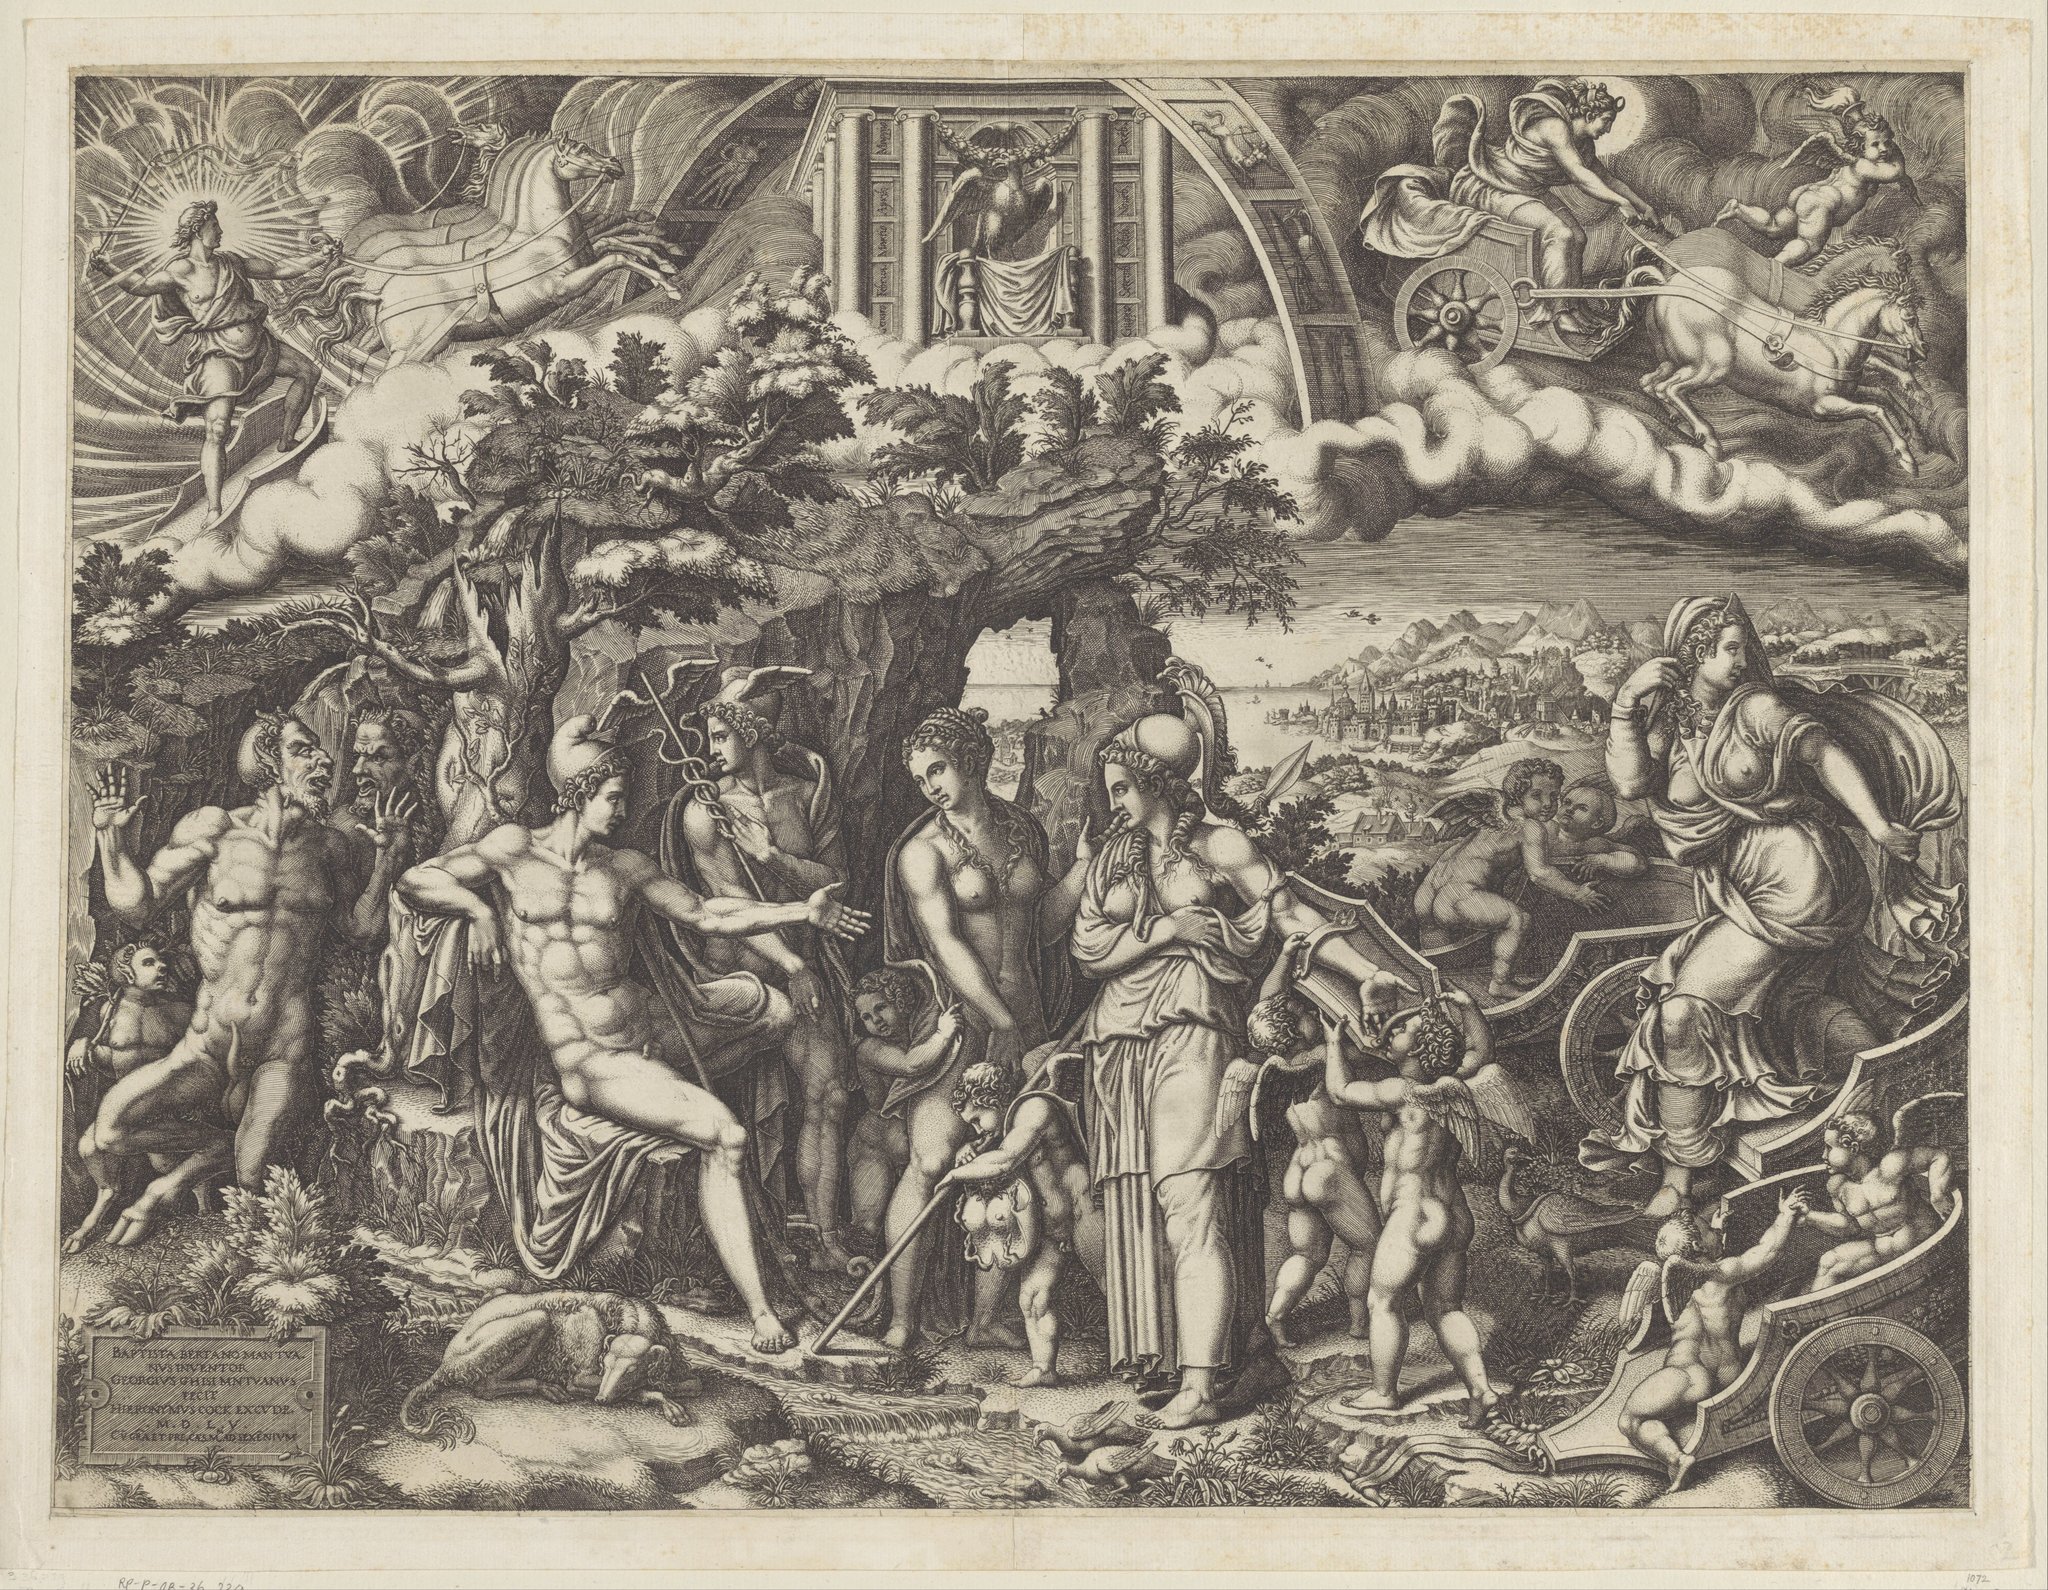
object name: print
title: Het oordeel van Paris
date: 1555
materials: paper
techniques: engraving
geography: italy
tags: the judgement of paris (mercury present)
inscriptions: collector's mark: Lugt 240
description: Het oordeel van Paris in een landschap. De zittende Paris maakt zijn keuze voor Venus. Achter hem staat Mercurius. Rechts staan Juno en Minerva, omringd door putti. Links twee oude en een jonge sater. Boven Apollo en Luna op hun wagens, voortgetrokken door paarden.